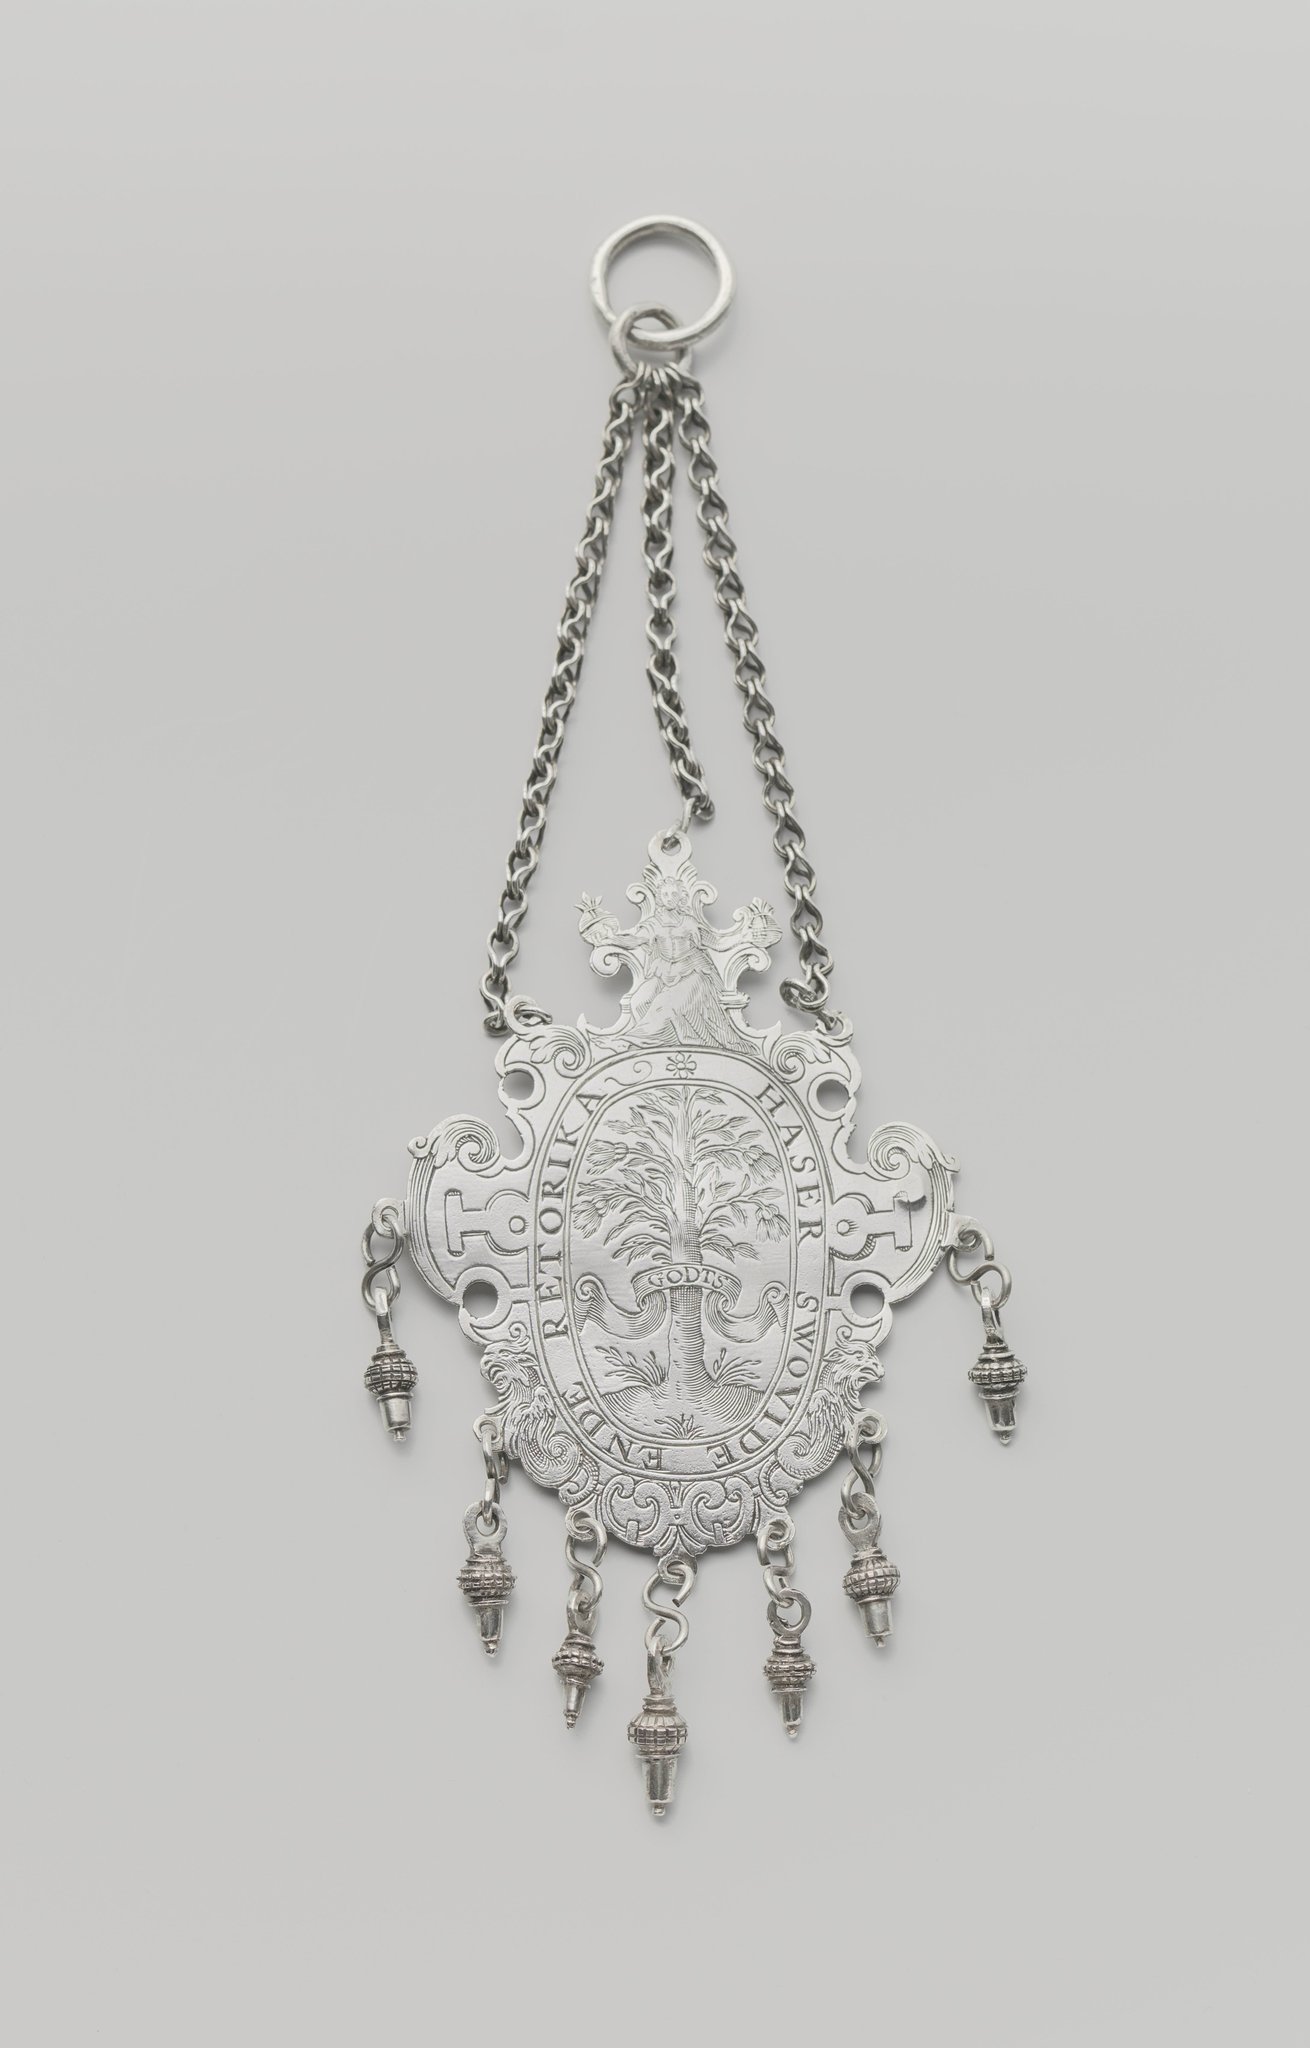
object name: insignia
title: Blazoen van de rederijkerskamer te Hazerswoude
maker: bartholomeus willemsz. dolendo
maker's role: print maker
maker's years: 1560-1626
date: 1600-1625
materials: silver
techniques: gilding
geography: leiden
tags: trees, ornaments ~ art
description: Draagteken van zilver van de Rederijkerskamer te Hazerswoude. Aan het cartouevormige schild hangen zeven eikels. Aan de voorzijde een gegraveerde boom waaromheen een banderolle; aan de achterzijde de Verrijzenis van Christus.